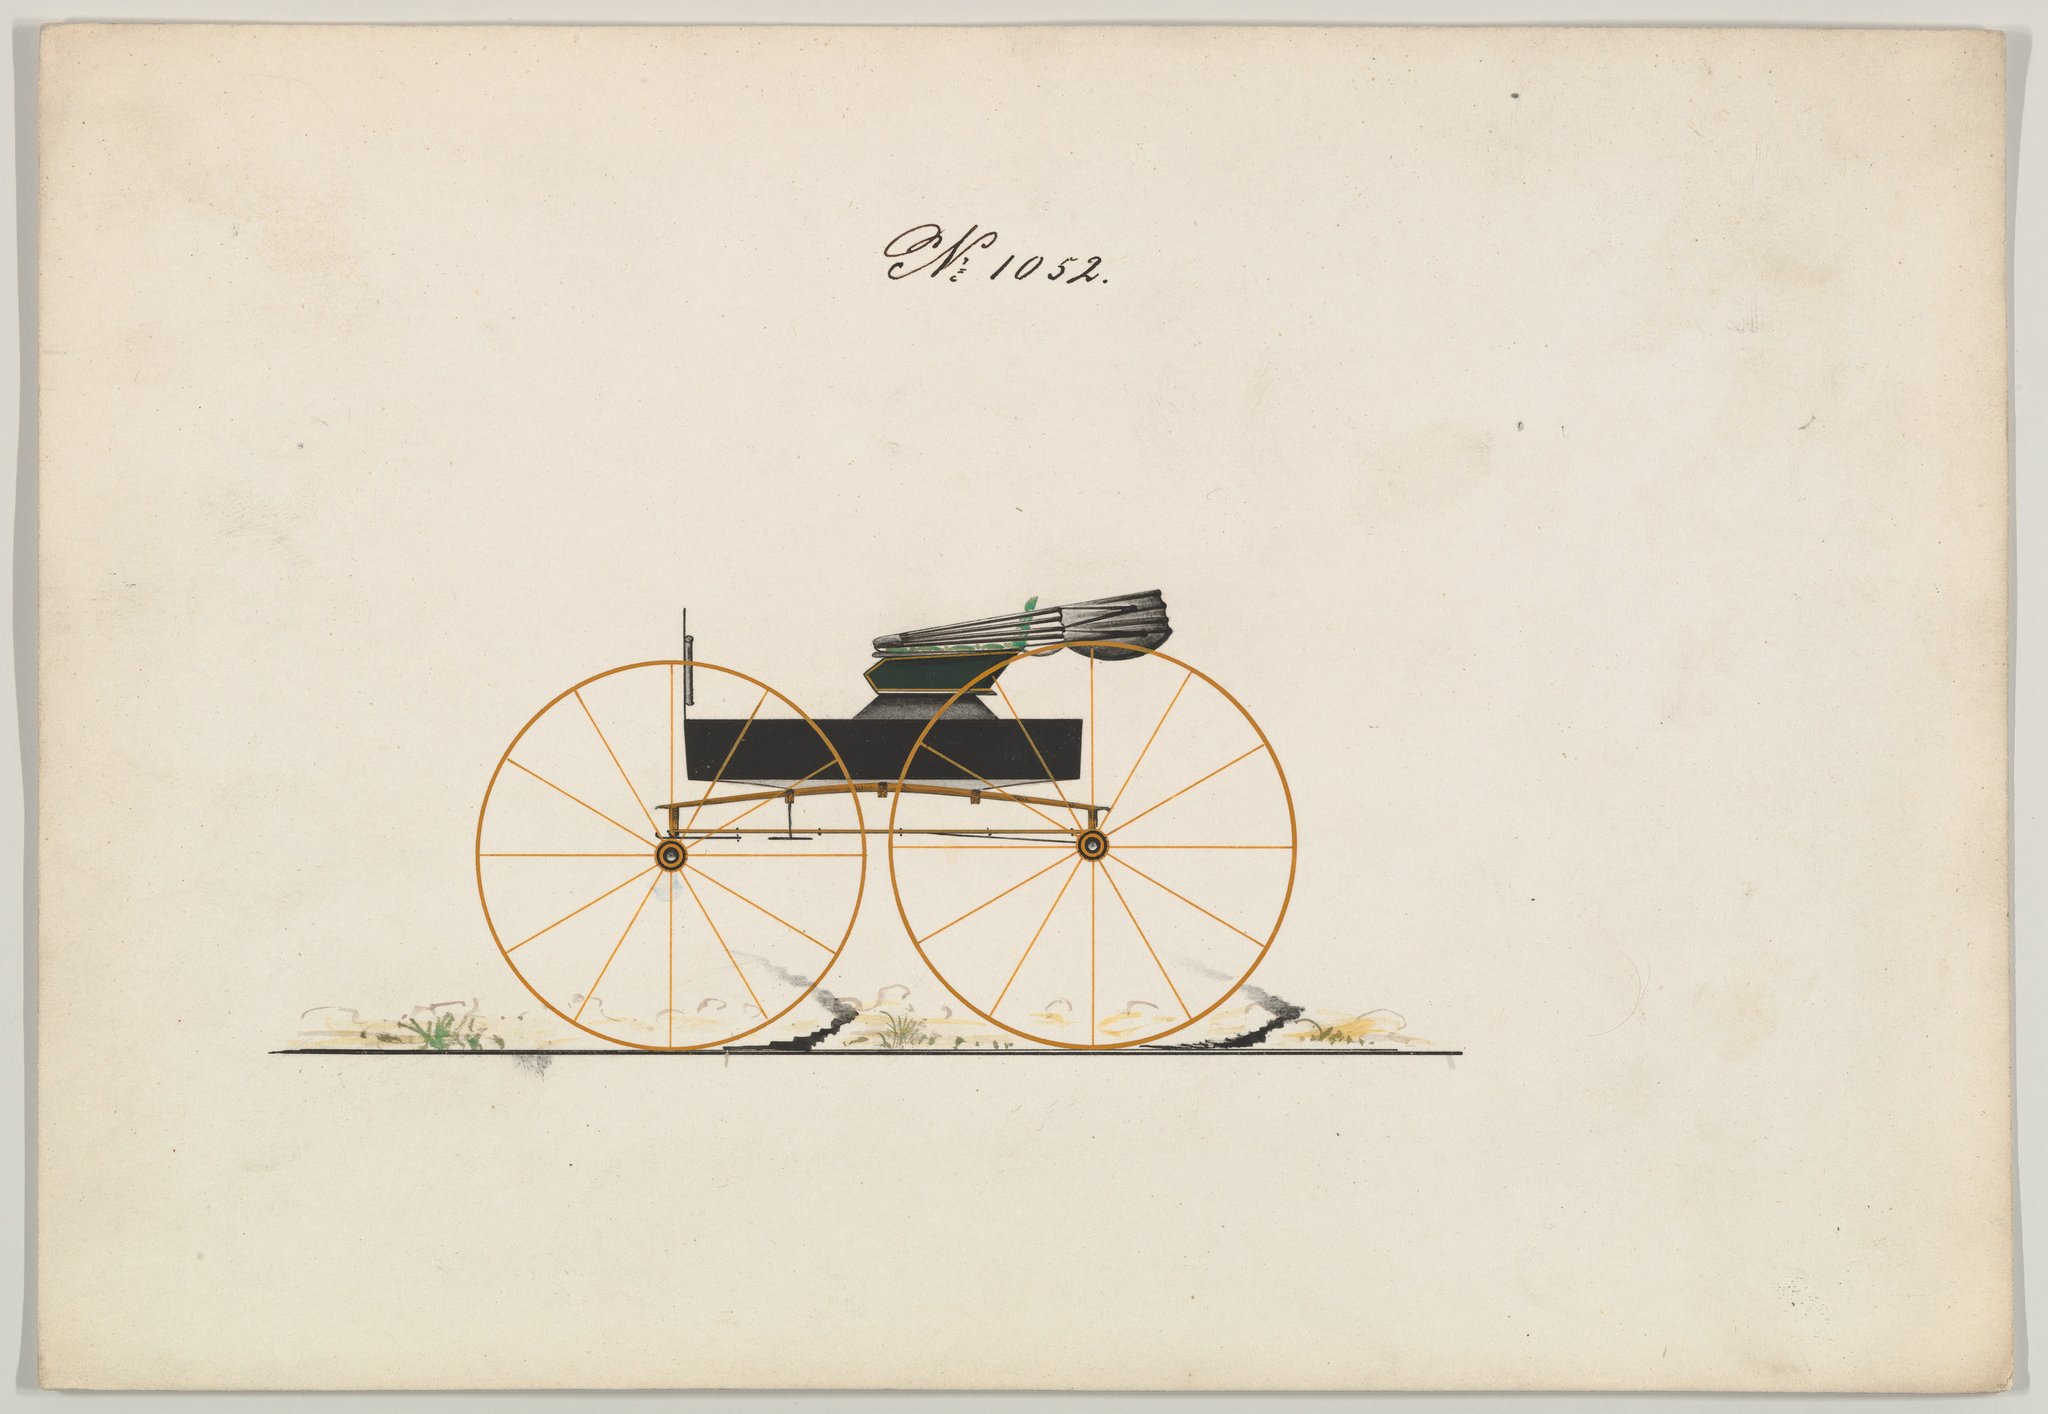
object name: drawing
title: Design for Wagon, no. 1052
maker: brewster & co.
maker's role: manufacturer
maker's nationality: american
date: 1850-1870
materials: gouache, gum arabic, ink, watercolor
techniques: pen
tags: carriages